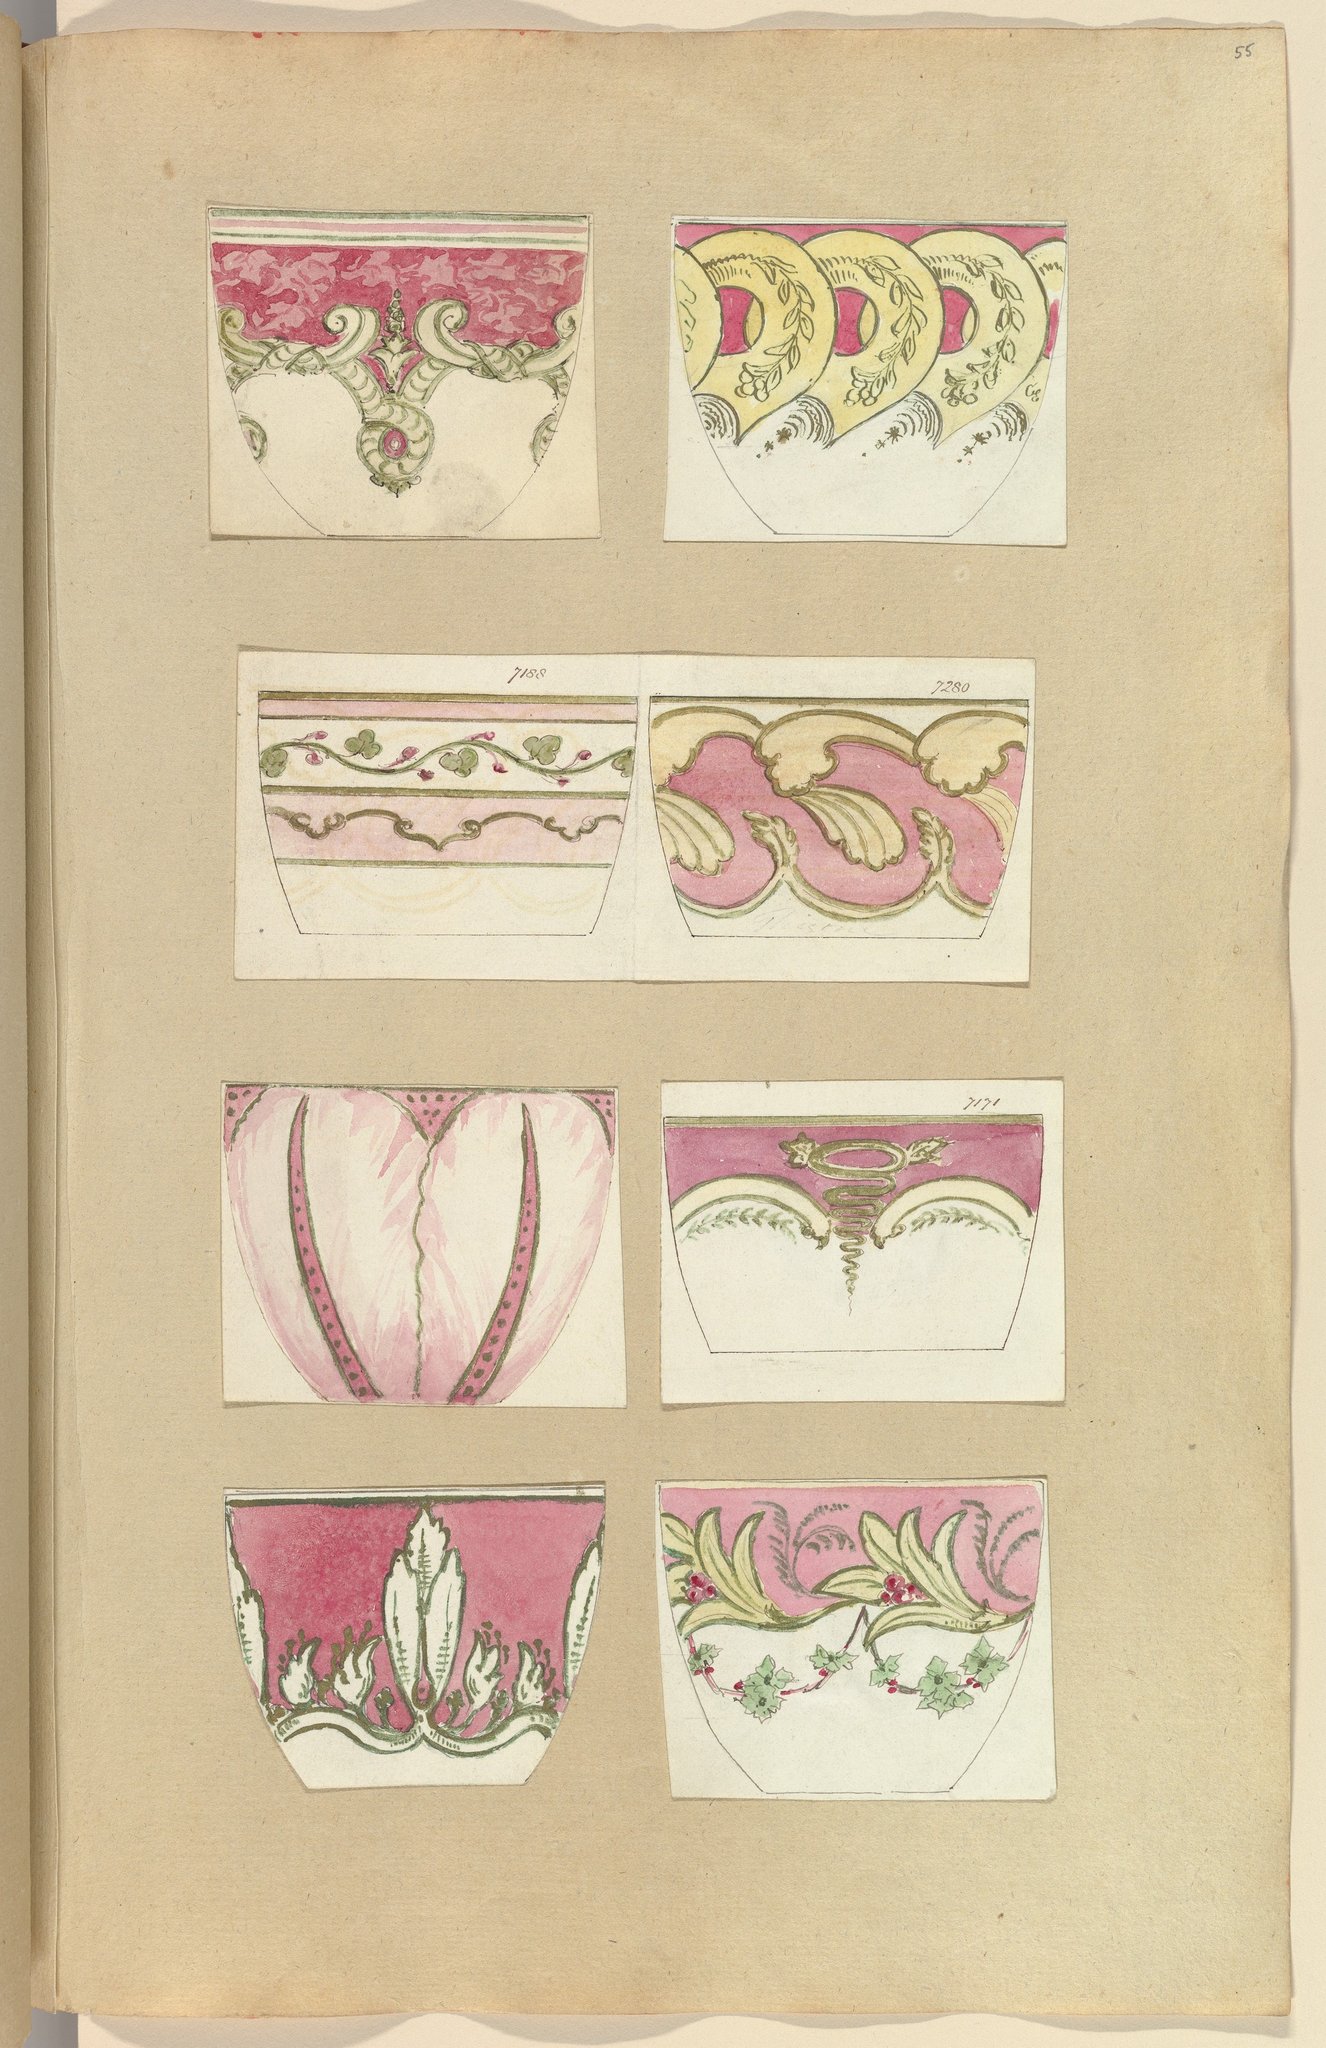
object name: drawing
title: Eight Designs for Decorated Cups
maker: alfred henry forrester [alfred crowquill]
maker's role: artist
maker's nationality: british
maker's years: 1804-1872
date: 1845-1855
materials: ink, watercolor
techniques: pen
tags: cups